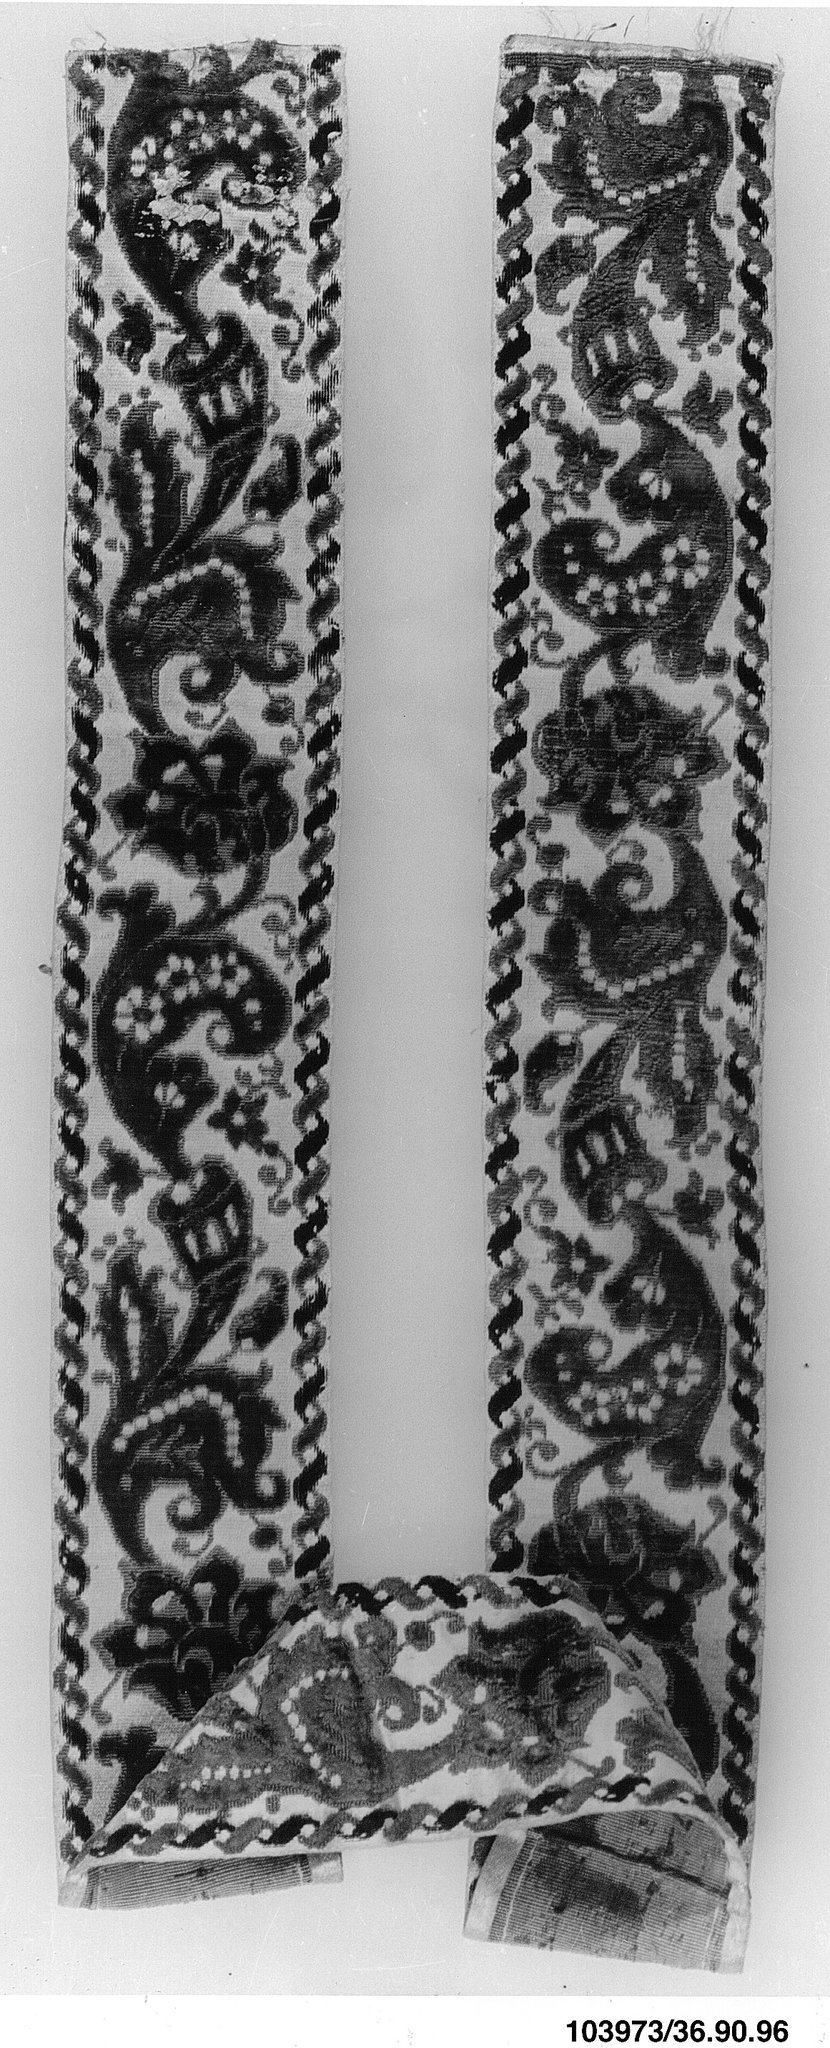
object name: border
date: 1601-1700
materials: silk